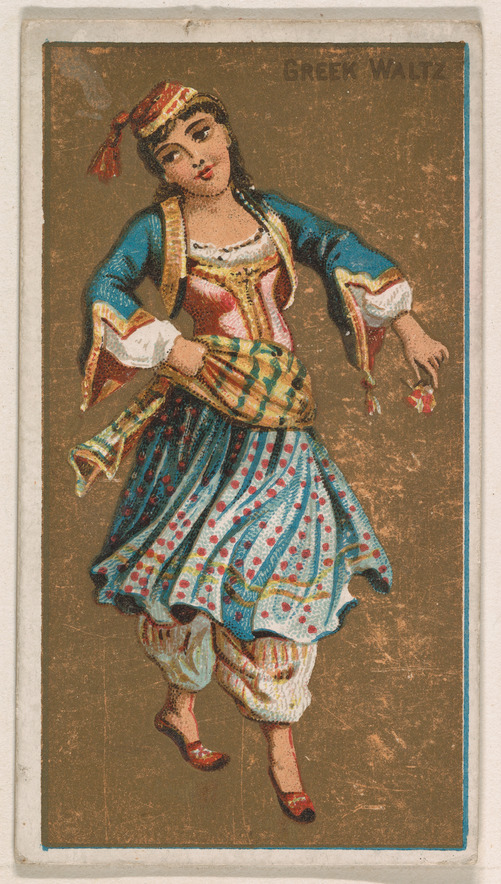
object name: print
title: Greek Waltz, from National Dances (N225, Type 1) issued by Kinney Bros.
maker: kinney brothers tobacco company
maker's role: publisher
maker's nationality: american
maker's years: 1869-2011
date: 1889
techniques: color lithograph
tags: women,dancing,dancers